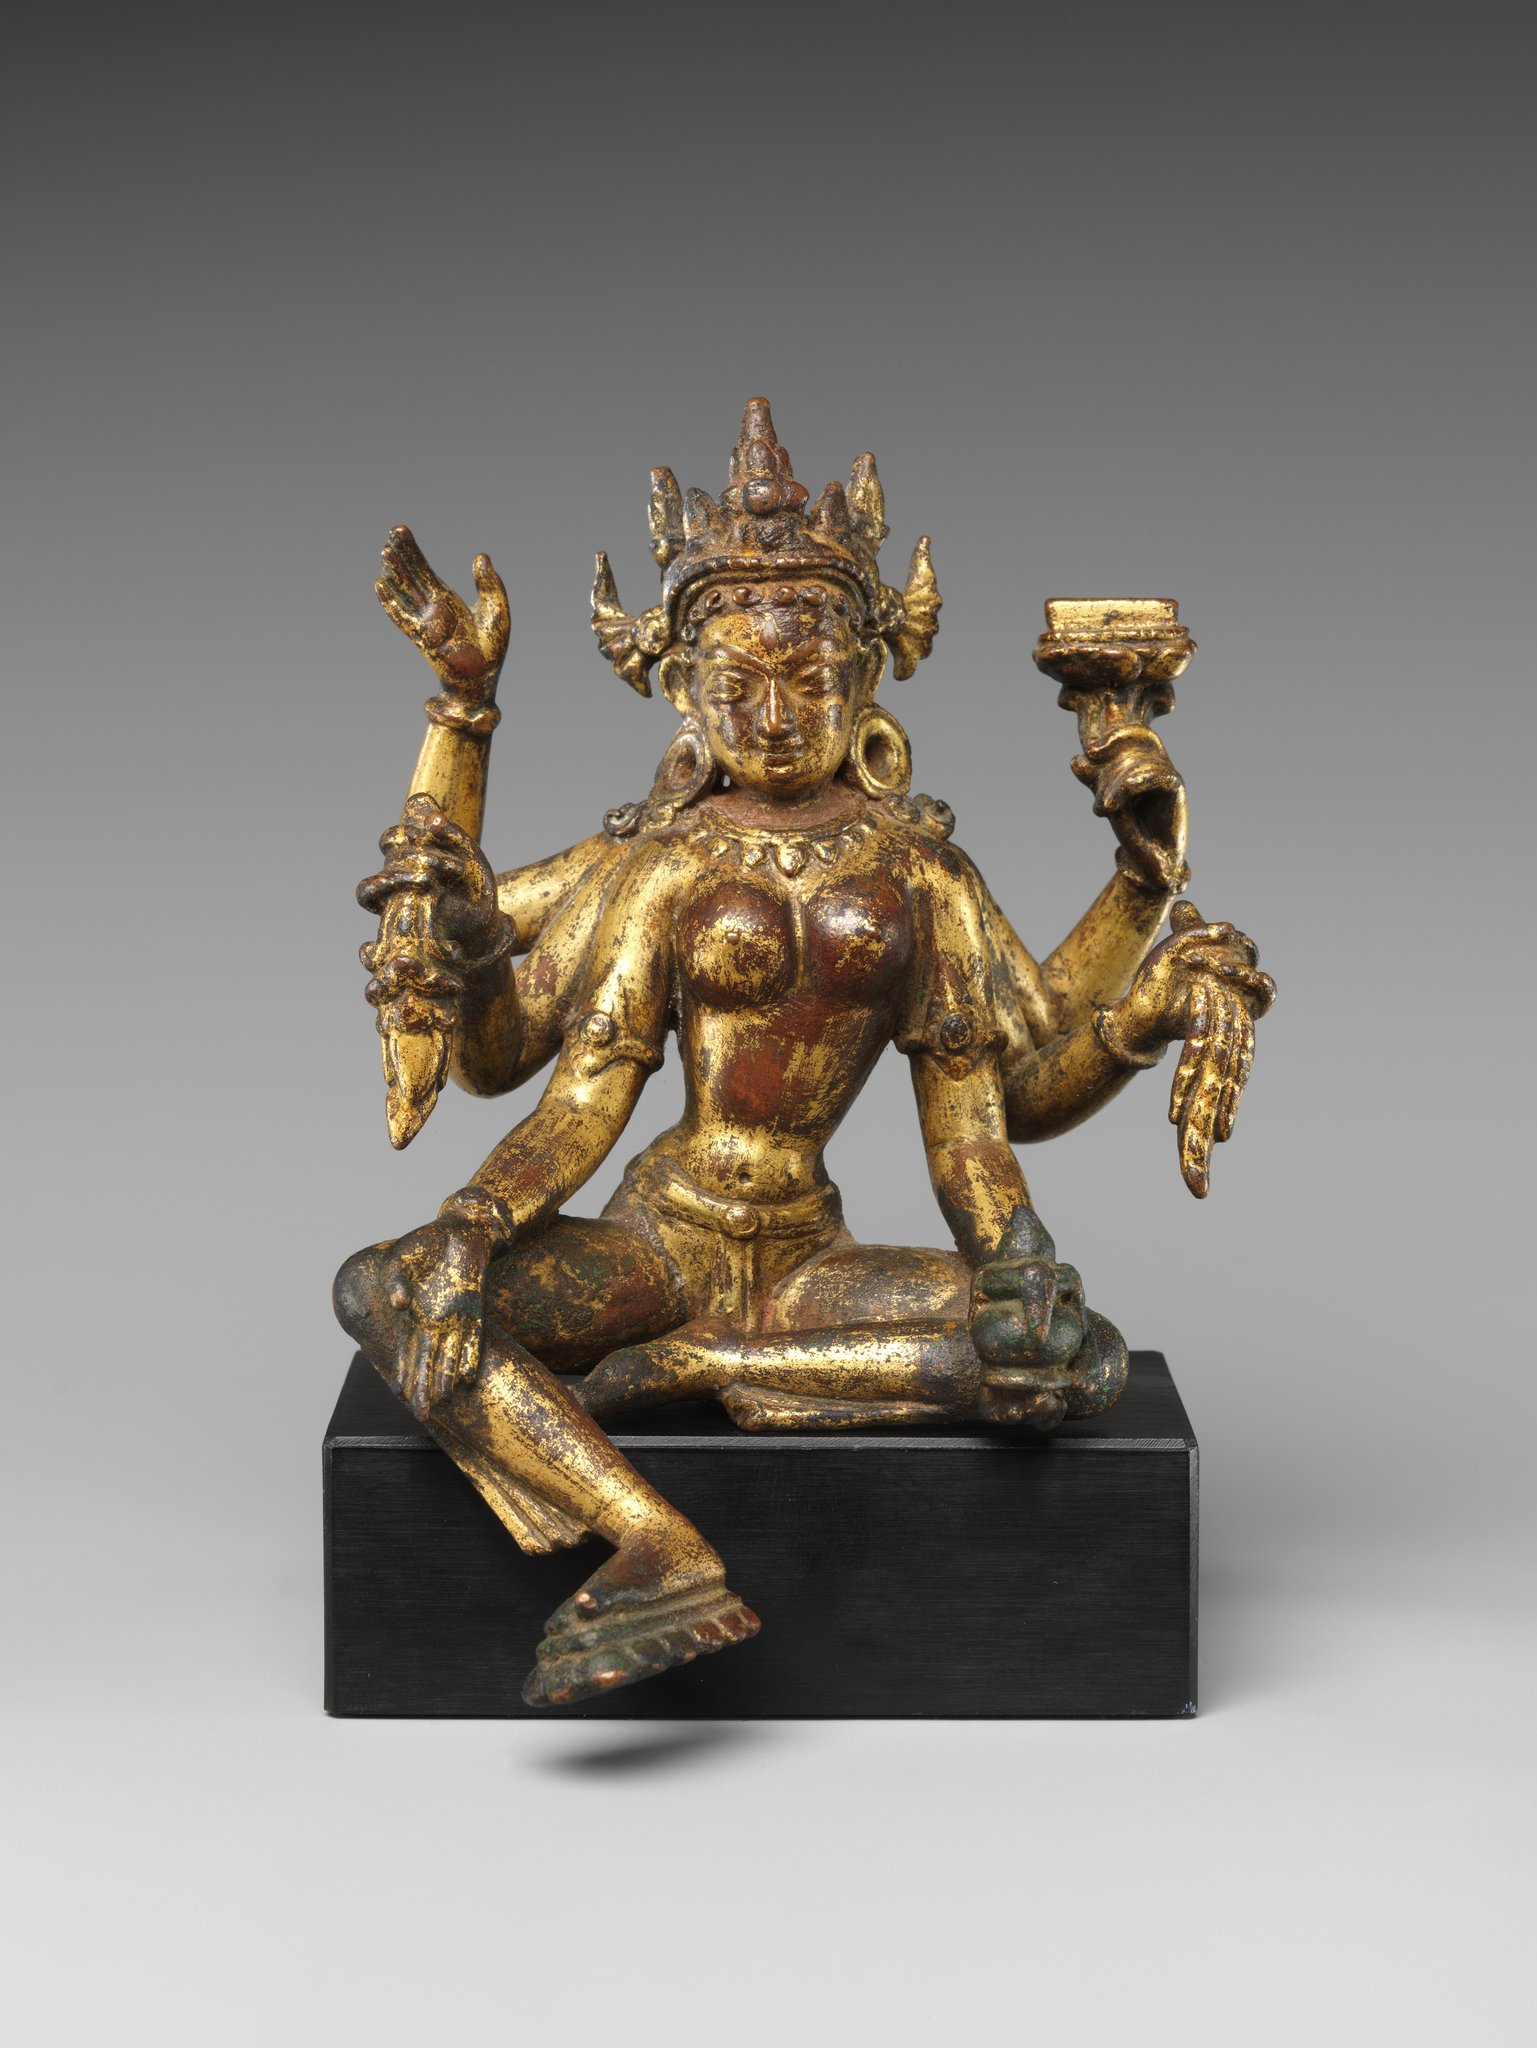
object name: figure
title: Vasudhara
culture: nepali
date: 1301-1500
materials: copper alloy, gilt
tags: buddhism,deities